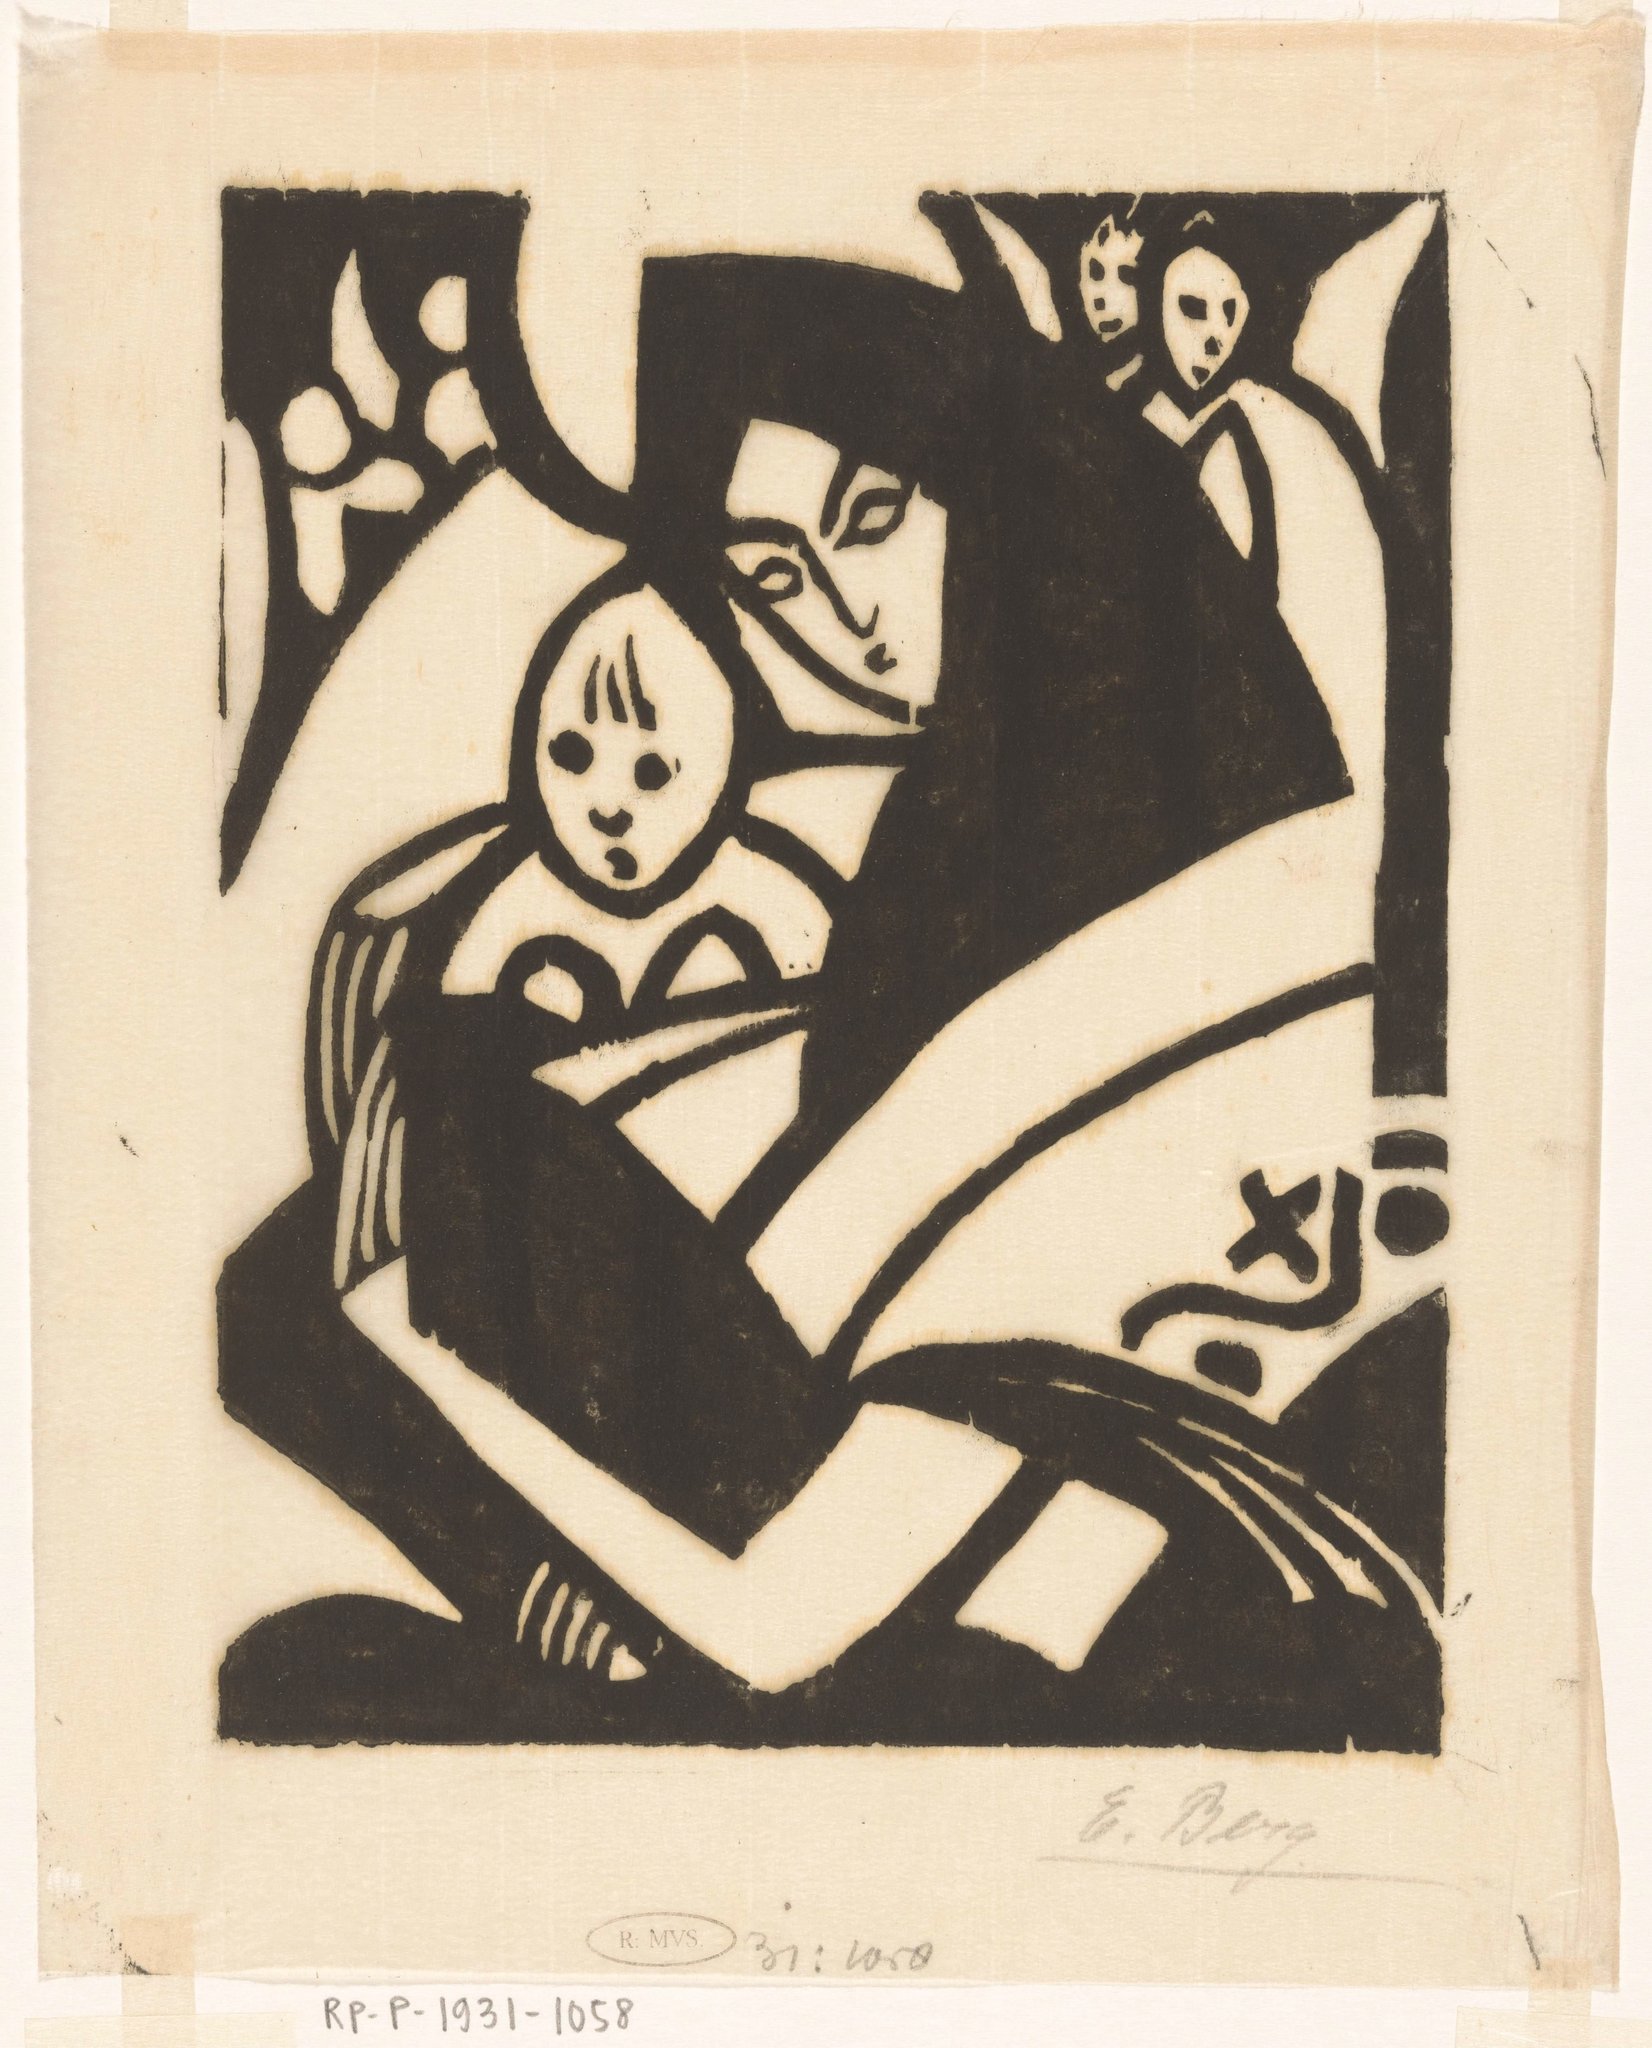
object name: print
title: Madonna met kind tegen wang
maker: else berg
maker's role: designer, draughtsman, painter, print maker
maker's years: 1877-1942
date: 1919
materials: paper, ink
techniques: woodcut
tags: mother and baby or young child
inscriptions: signature: ‘E. Berg’, collector's mark: Lugt 2228, number: ‘1’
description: Vrouw met hoofddoek en een kind in haar armen die ze tegen haar wang duwt, met op de achtergrond twee andere figuren; gestileerd weergegeven.